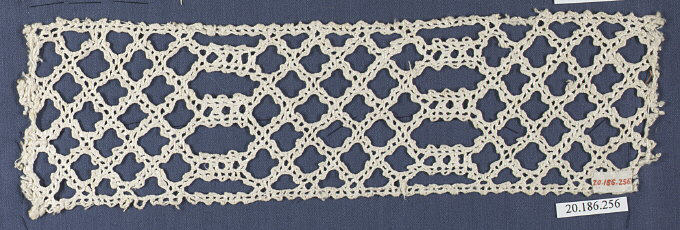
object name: insertion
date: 1501-1600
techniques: lace